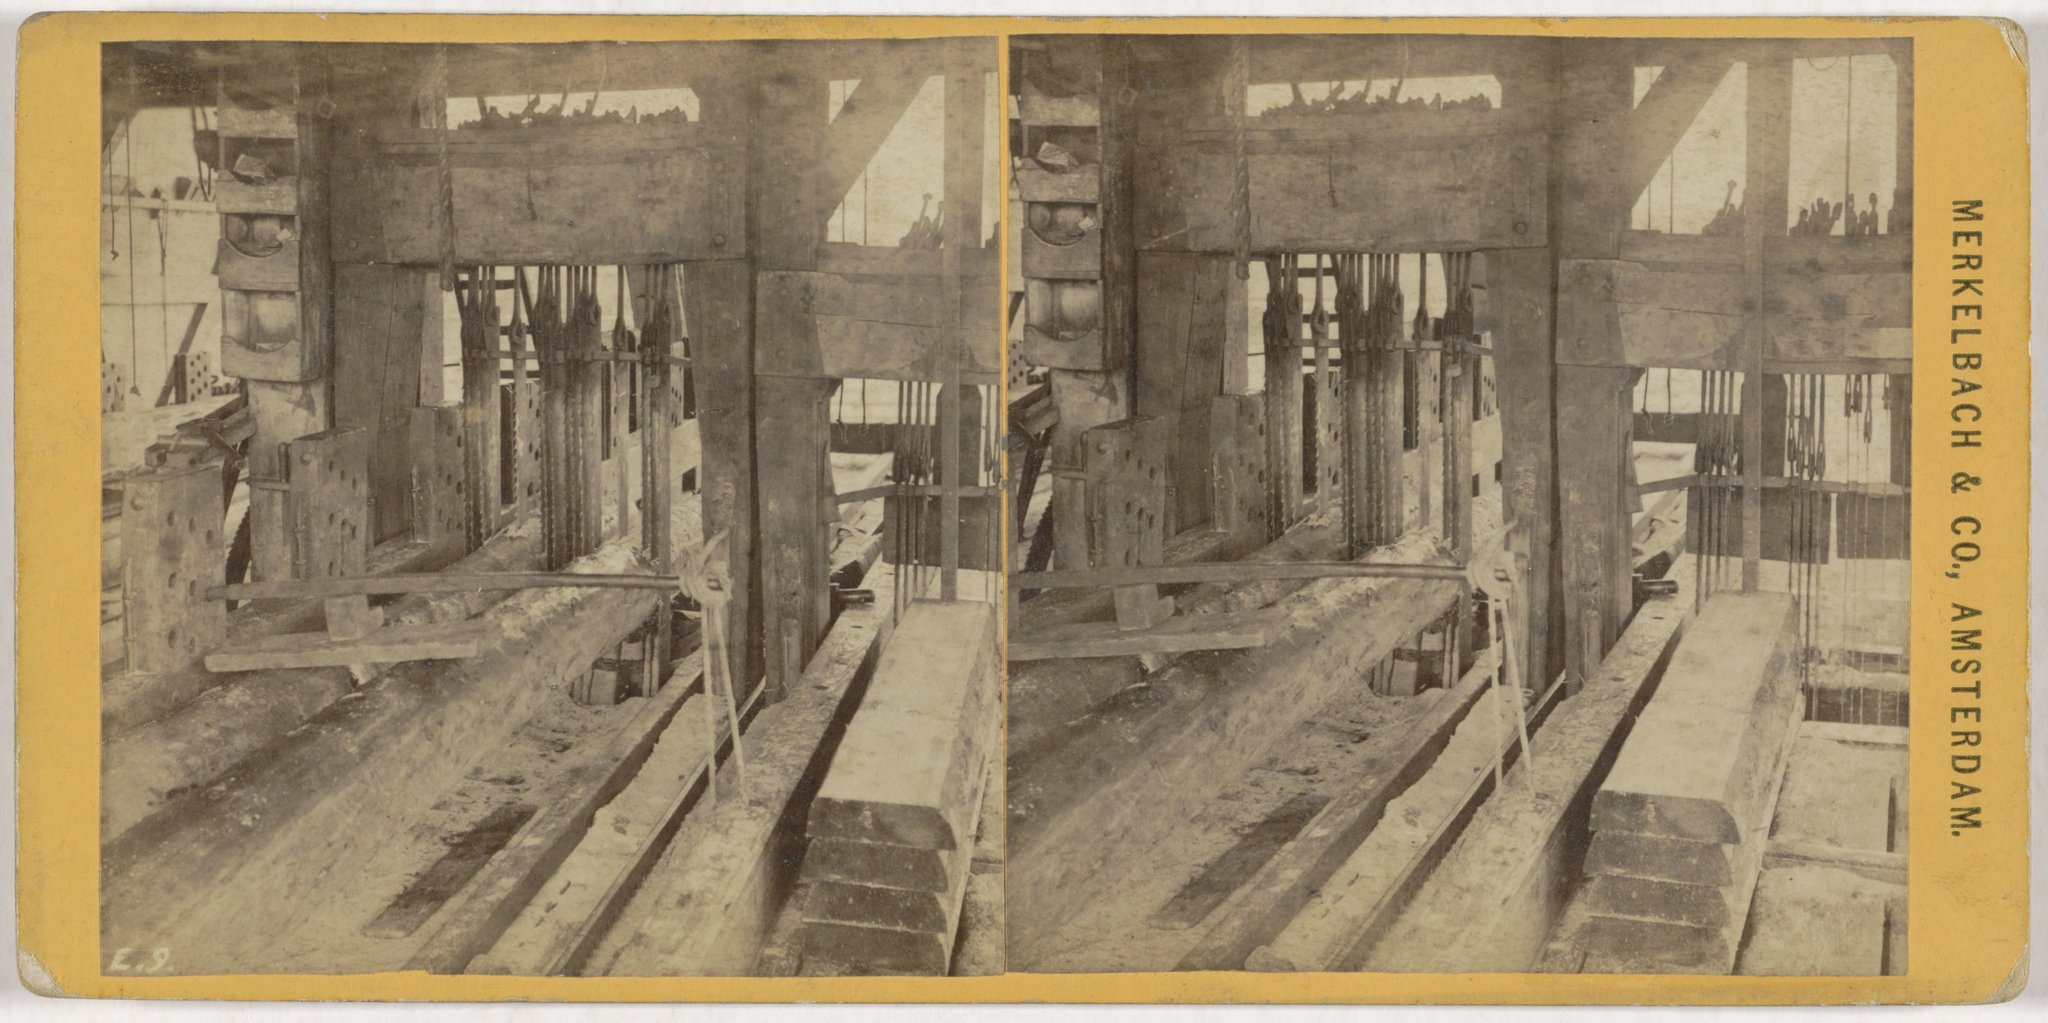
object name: stereograph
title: Aardrijkskundige beeldengalerij, verzameld door M.J. Broekhuijsen, hoofd eener school te Amsterdam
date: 1900-1902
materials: cardboard, paper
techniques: albumen print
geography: amsterdam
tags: interior of industrial structures (regardless of the materials processed or the products made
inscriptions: number: ‘E.9.’, number: ‘9.’, inscription: ‘(Zie pl. 8.)’